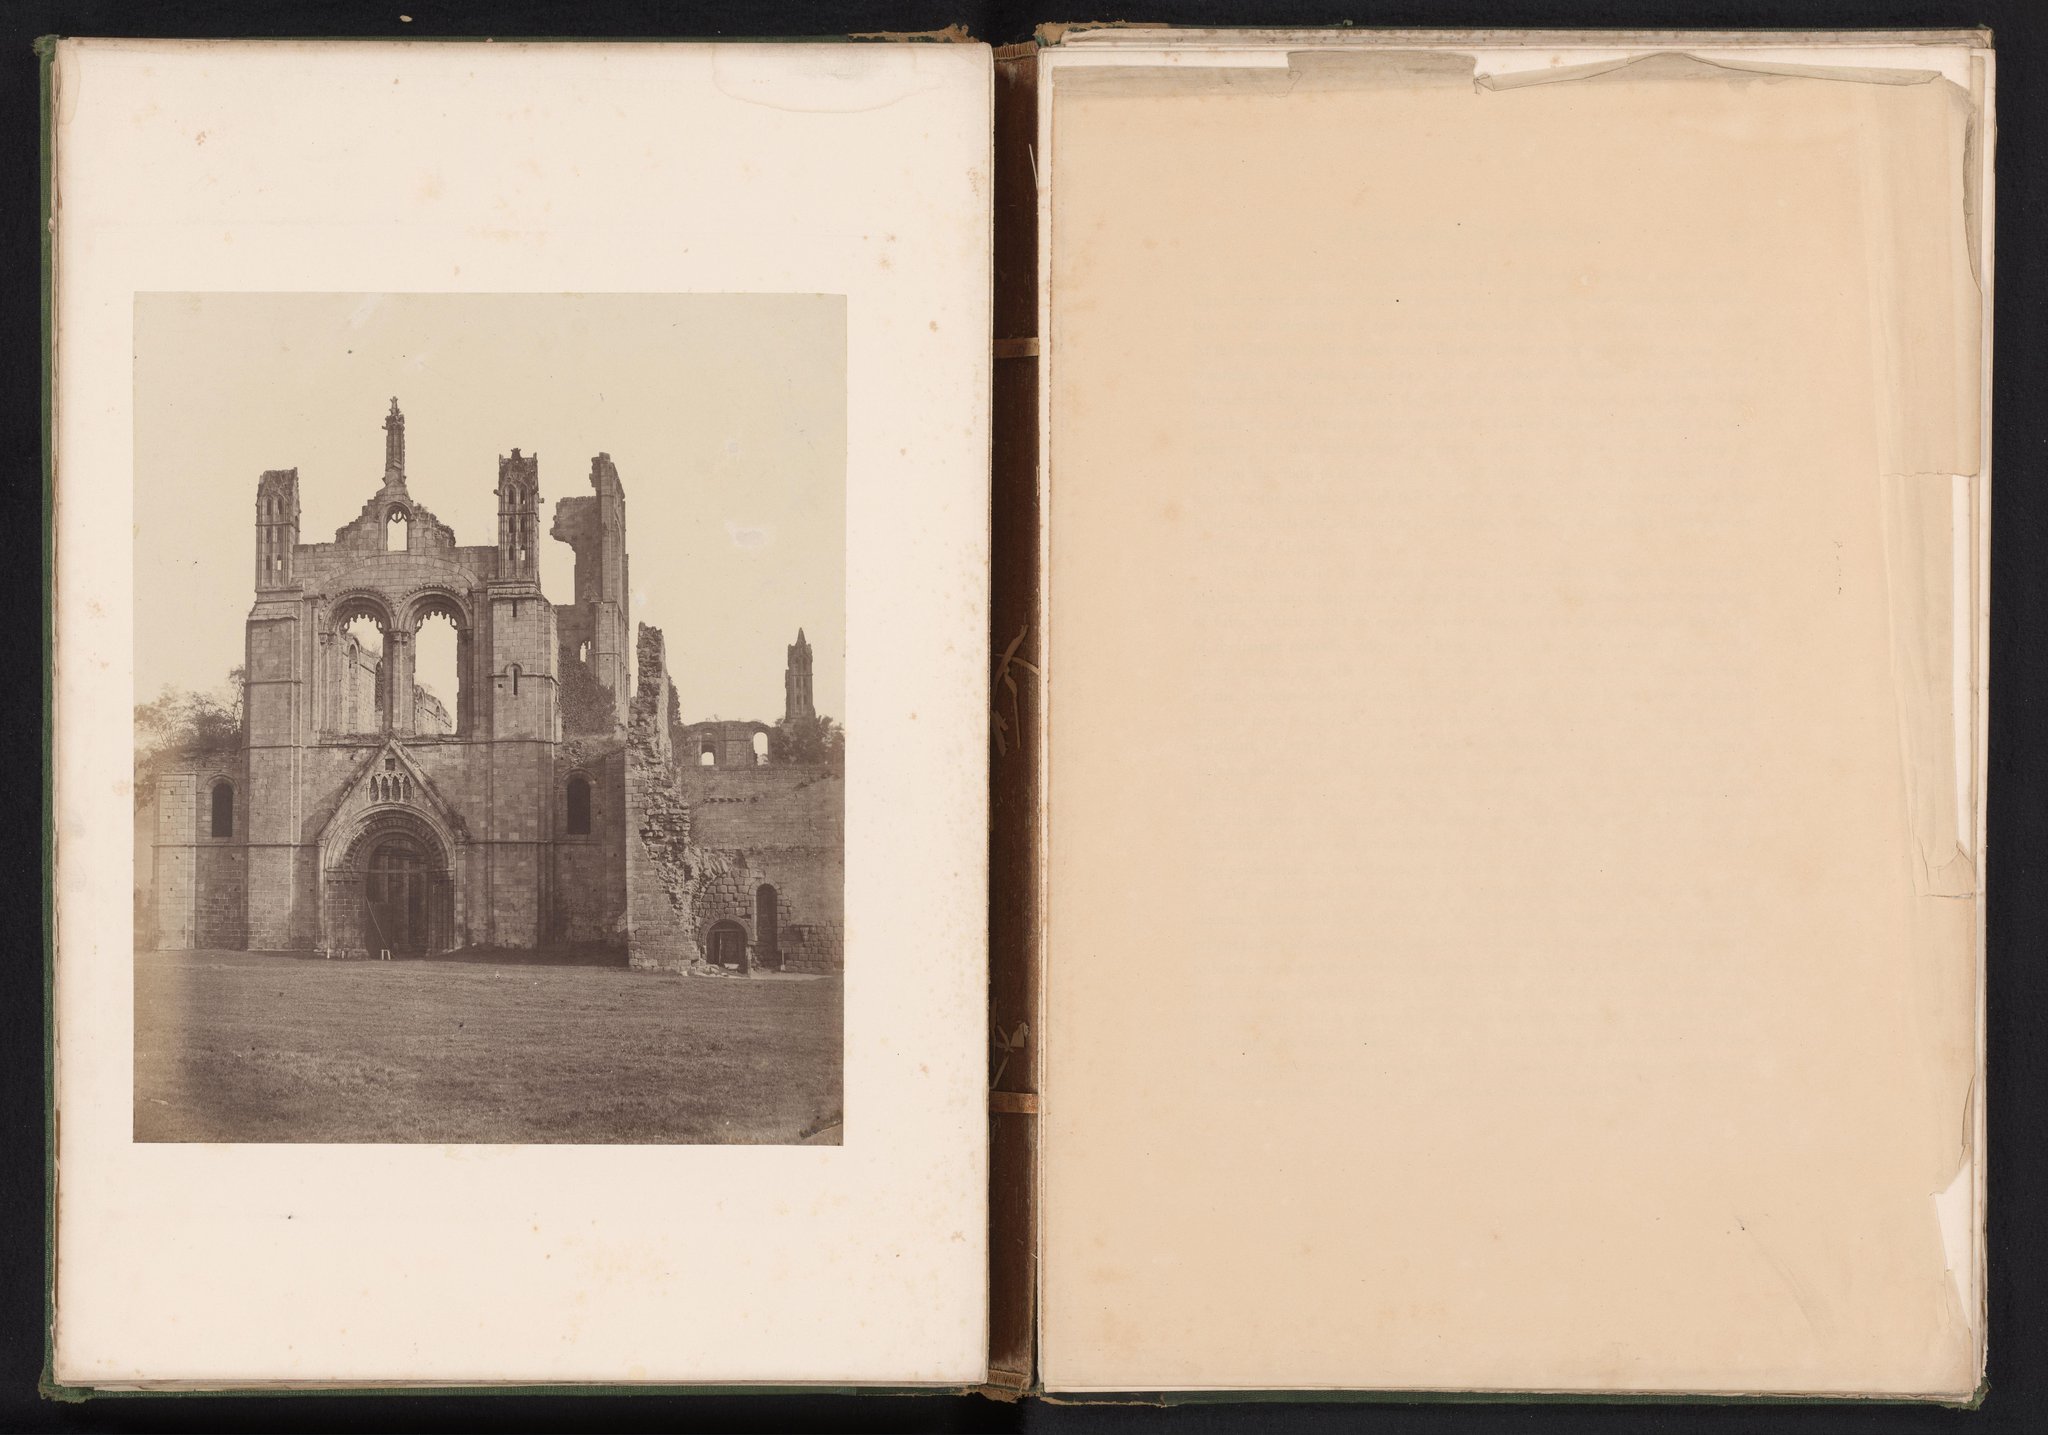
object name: photograph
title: Westzijde van de Krikstall Abbey te Leeds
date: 1851-1856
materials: photographic support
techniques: albumen print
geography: kirkstall abbey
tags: landscape with ruins, ruin of church, monastery, etc.